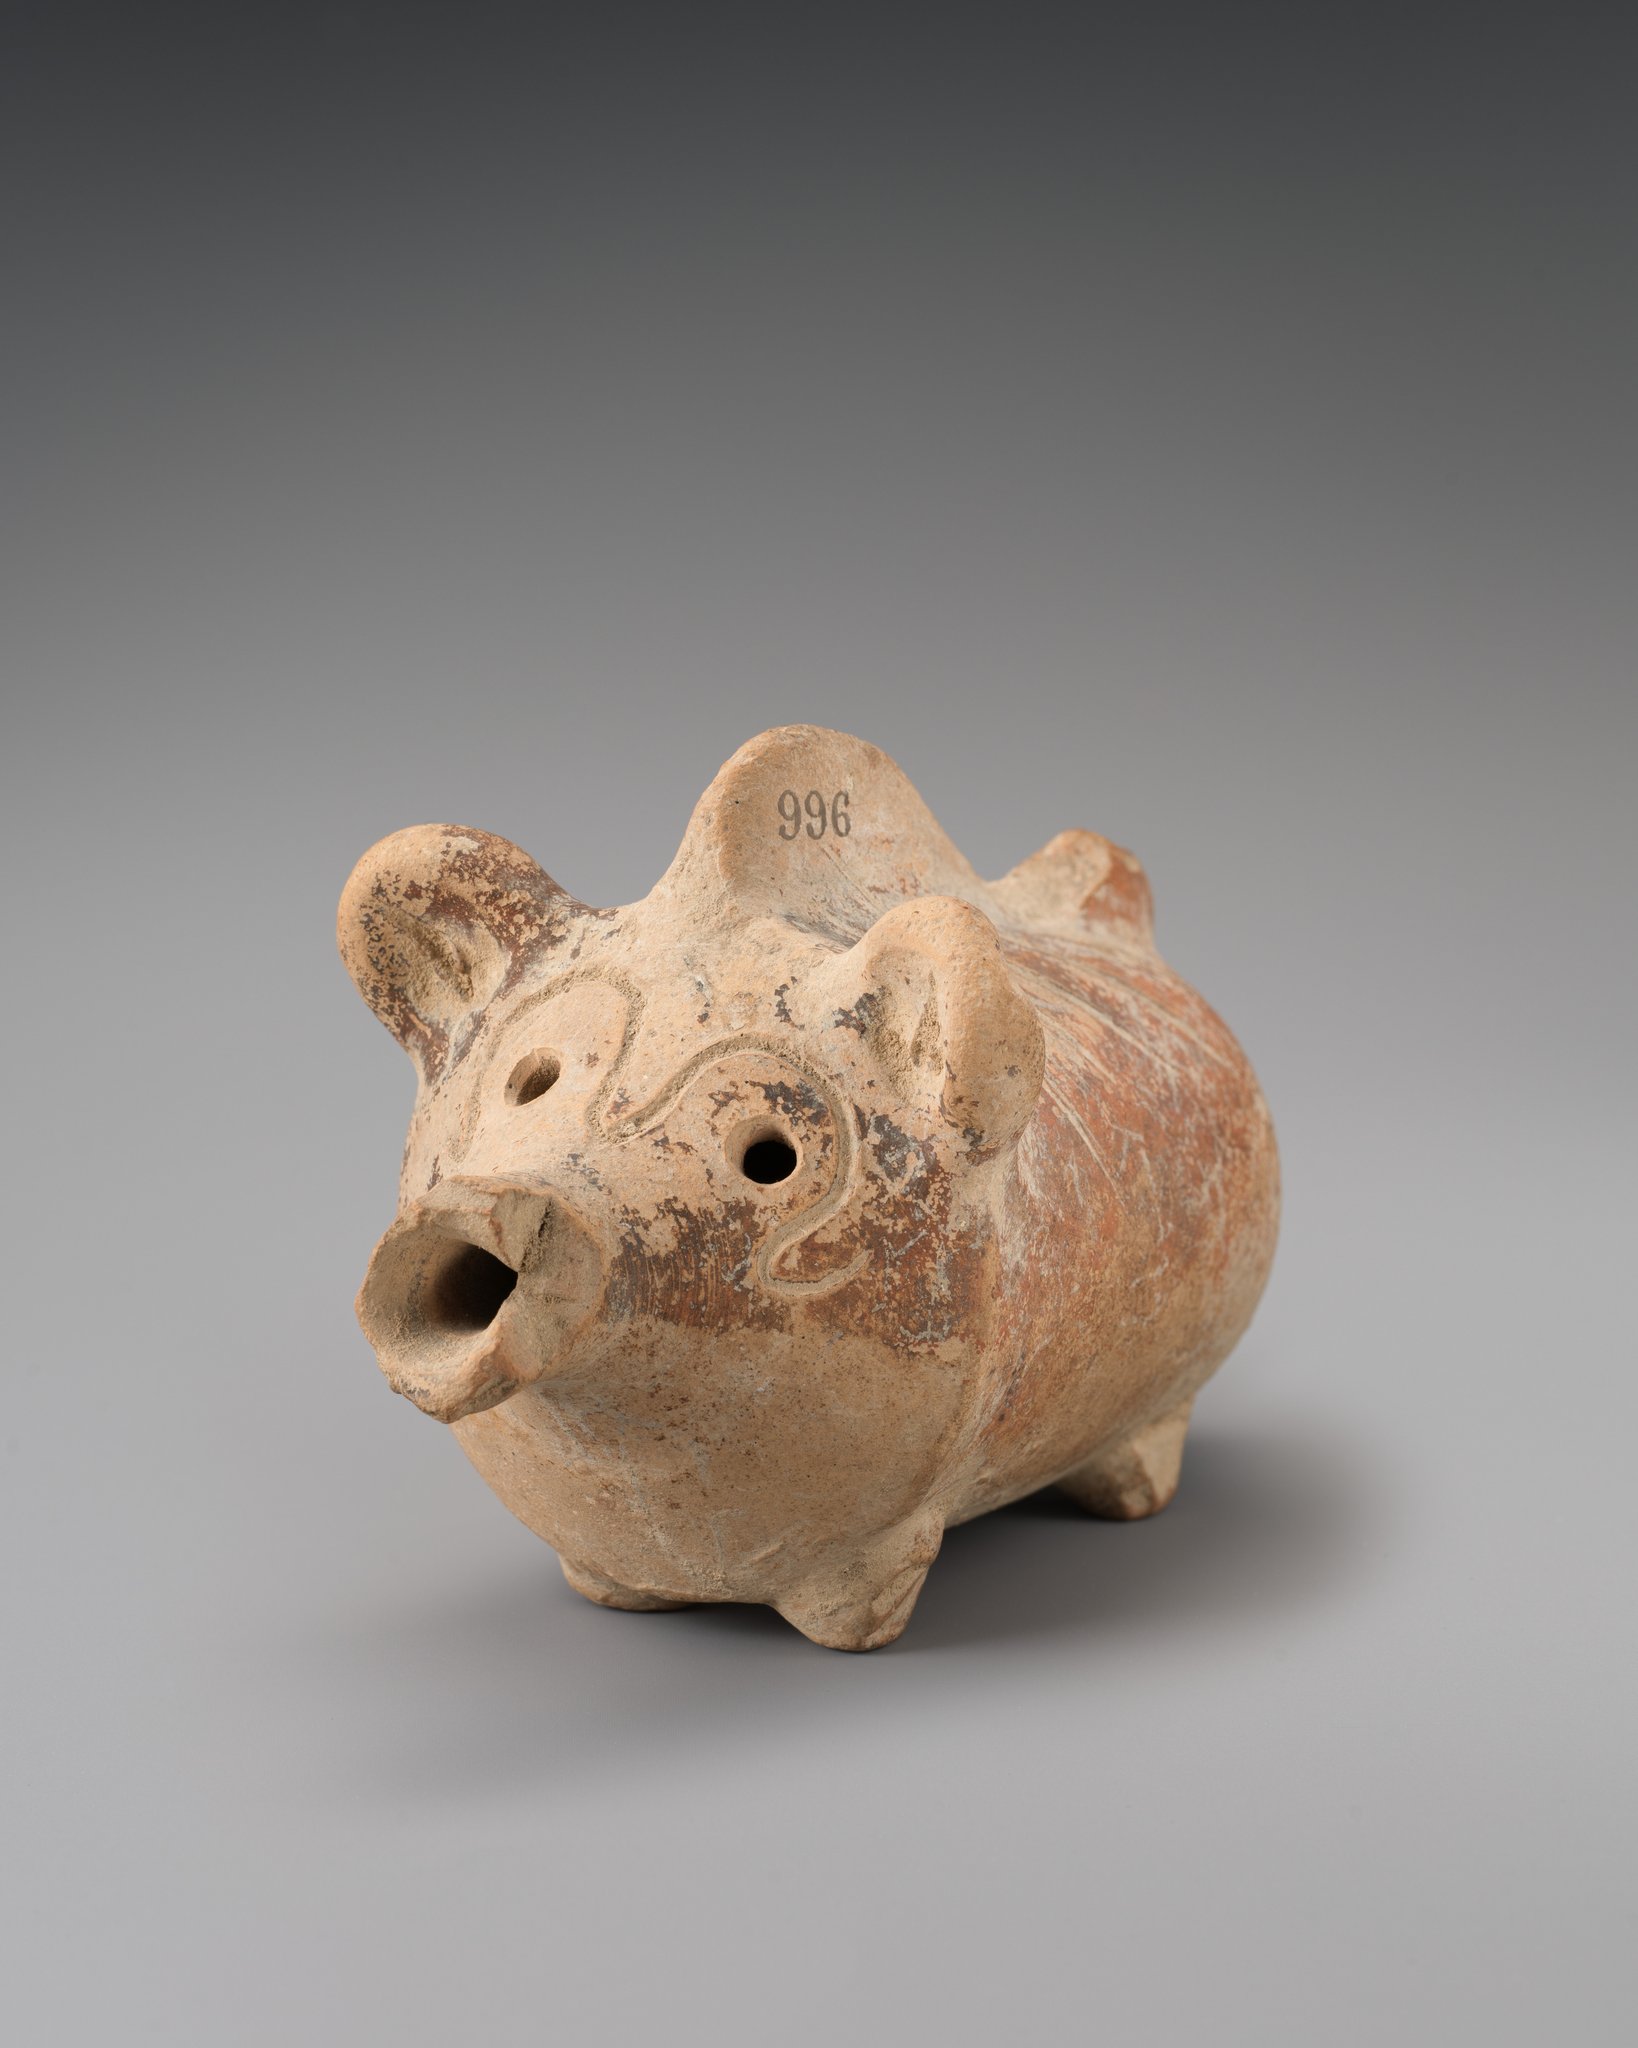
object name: rattle in the form of a pig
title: Terracotta rattle in the form of a pig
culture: cypriot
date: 300-101 BCE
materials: terracotta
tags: pigs